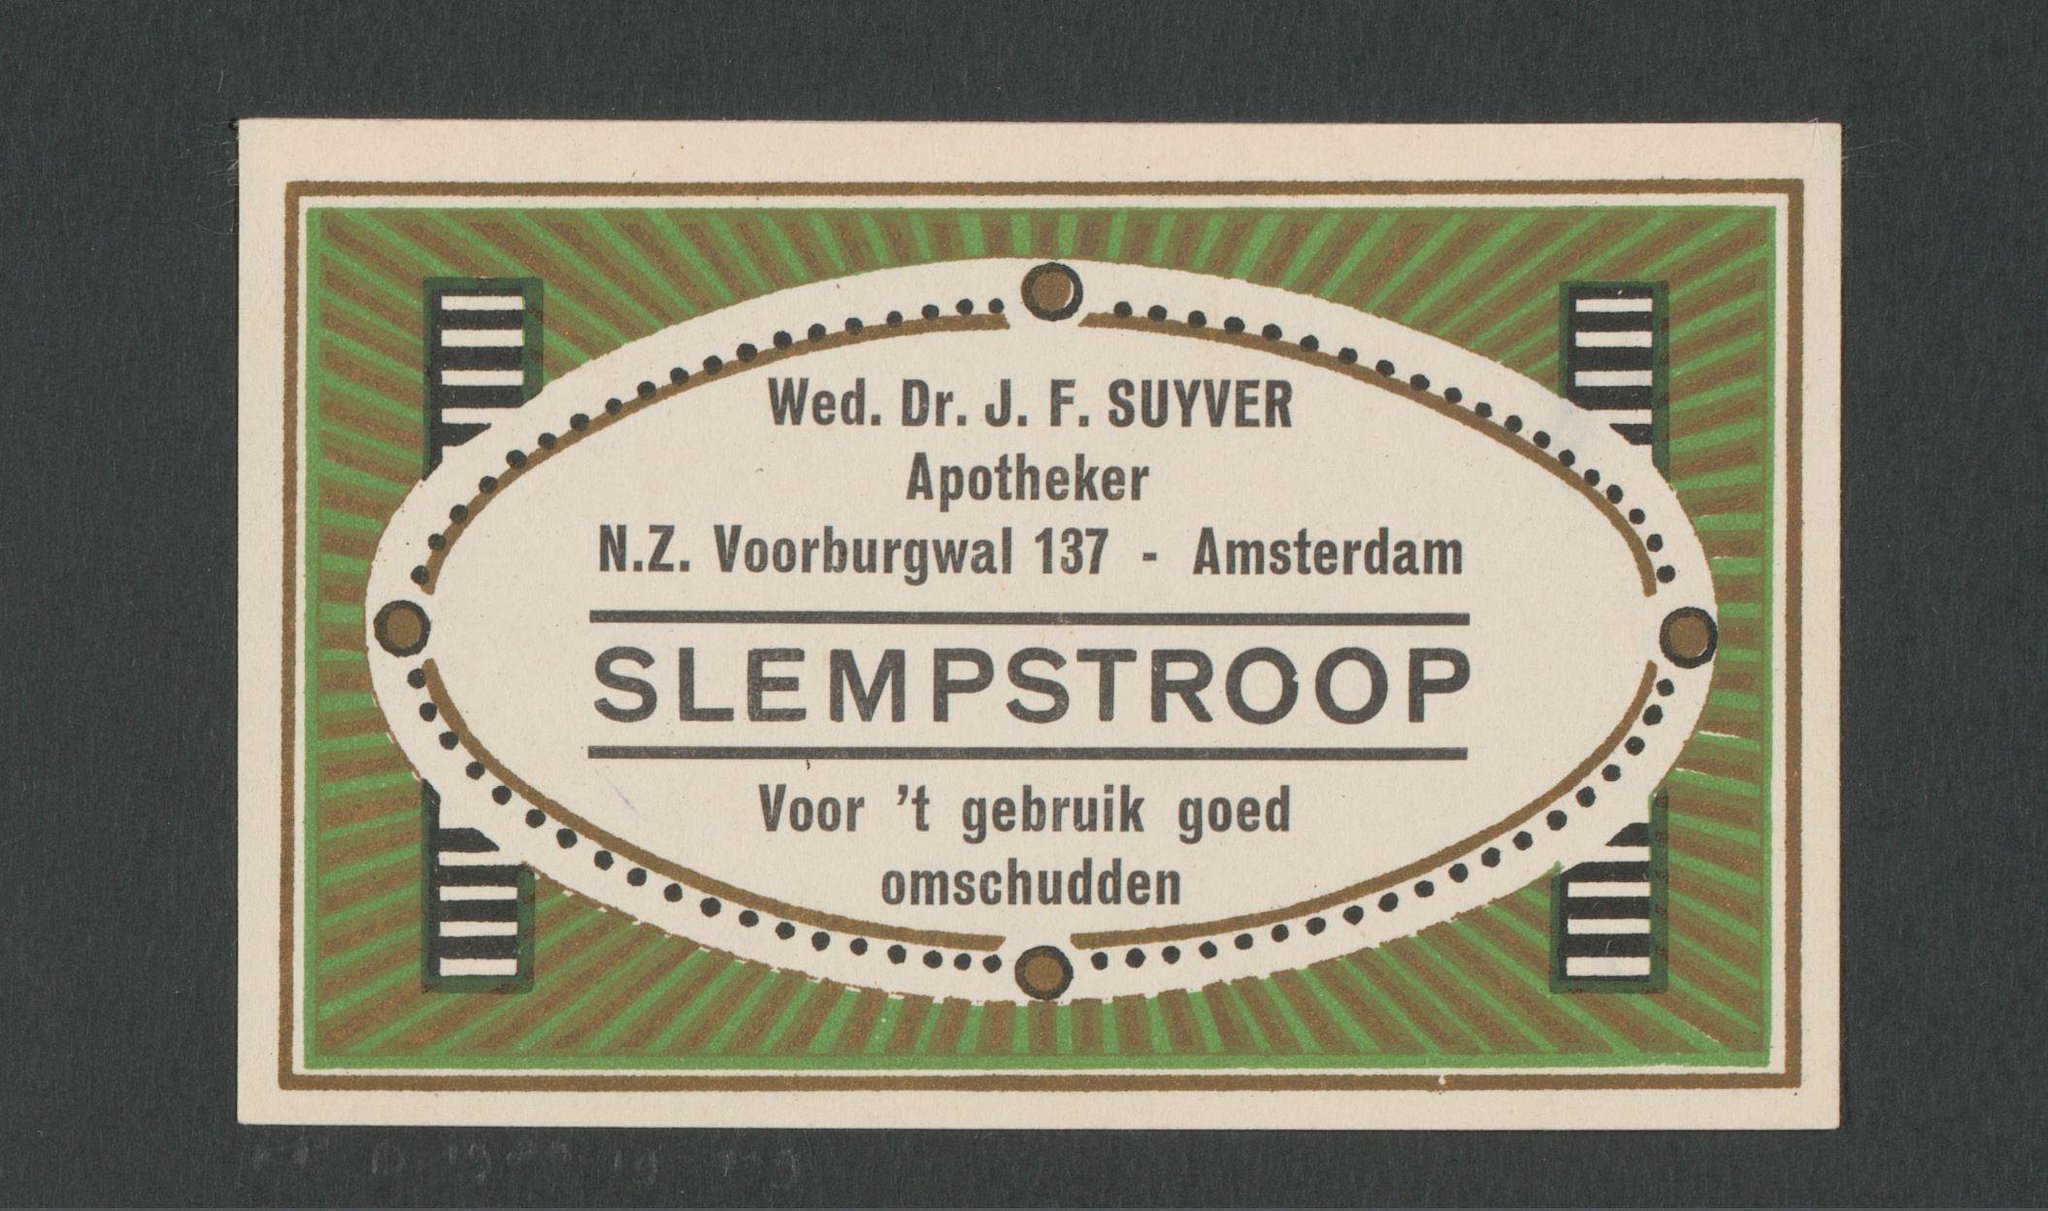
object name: print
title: Apothekersetiket voor slempstroop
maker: Anonymous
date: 1884-1952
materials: paper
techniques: lithograph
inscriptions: collector's mark: ‘R:MVS.’